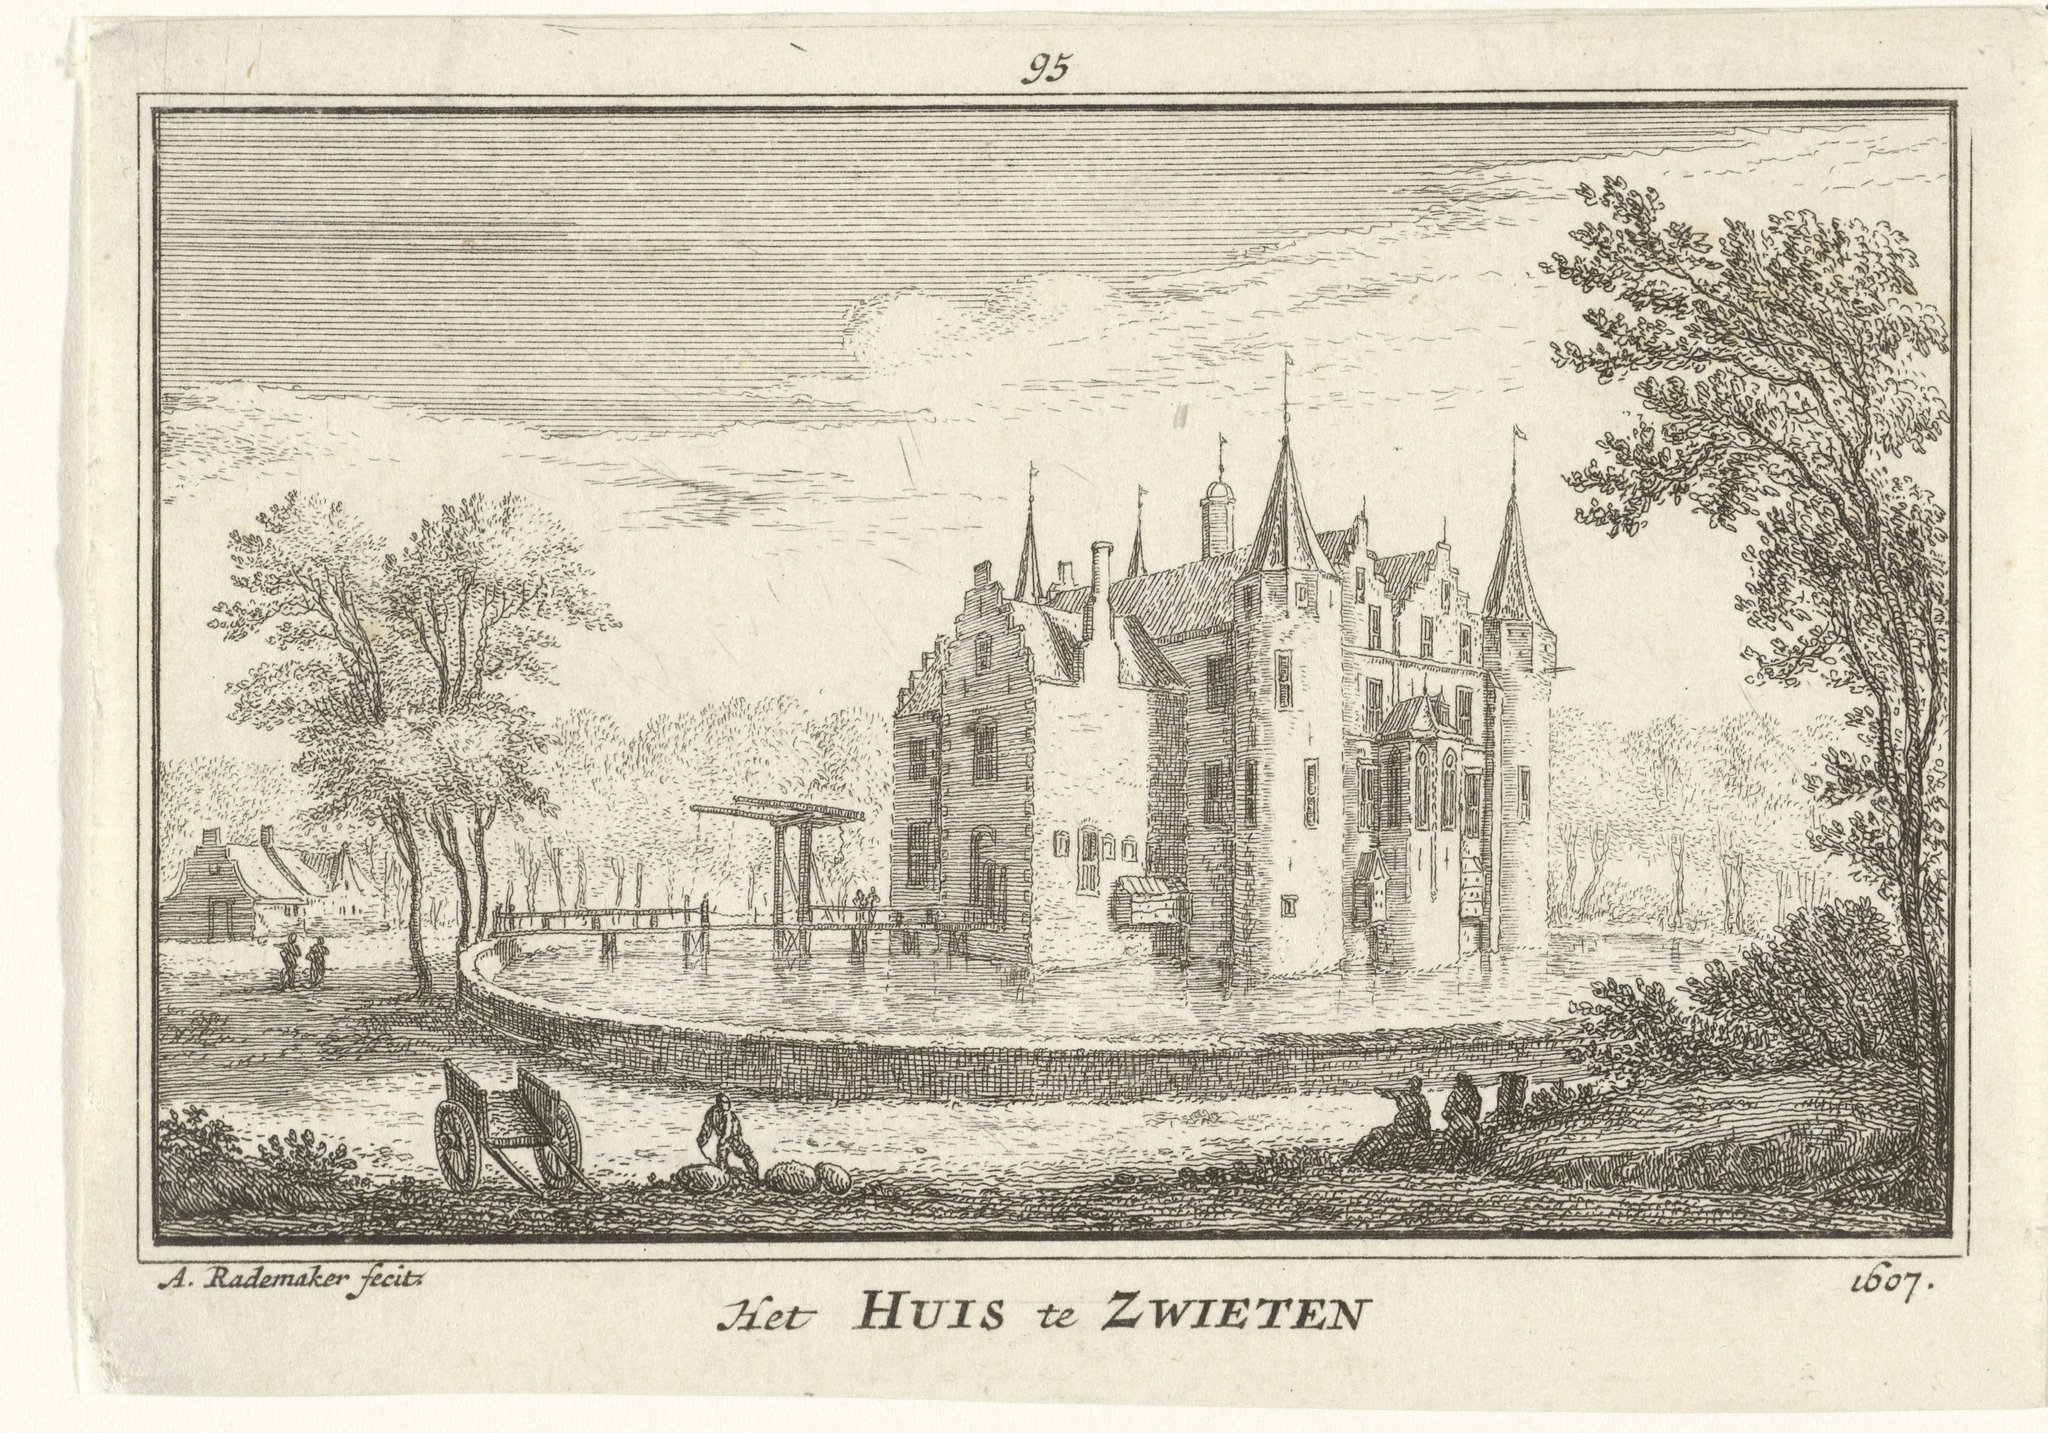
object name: book illustration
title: Gezicht op Huis te Swieten, 1607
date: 1727-1733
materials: paper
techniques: etching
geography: amsterdam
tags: castle, bridge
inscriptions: collector's mark: Lugt 2228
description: Illustratie uit: Abraham Rademaker, Matthaeus Brouërius van Niedek, Isaac Le Long, Kabinet van Nederlandsche en Kleefsche outheden en (...) voorname stads- en landgebouwen, Willem Barents en Antoni Schoonenburg: Amsterdam, 1727-1733, ill. nr. 95.